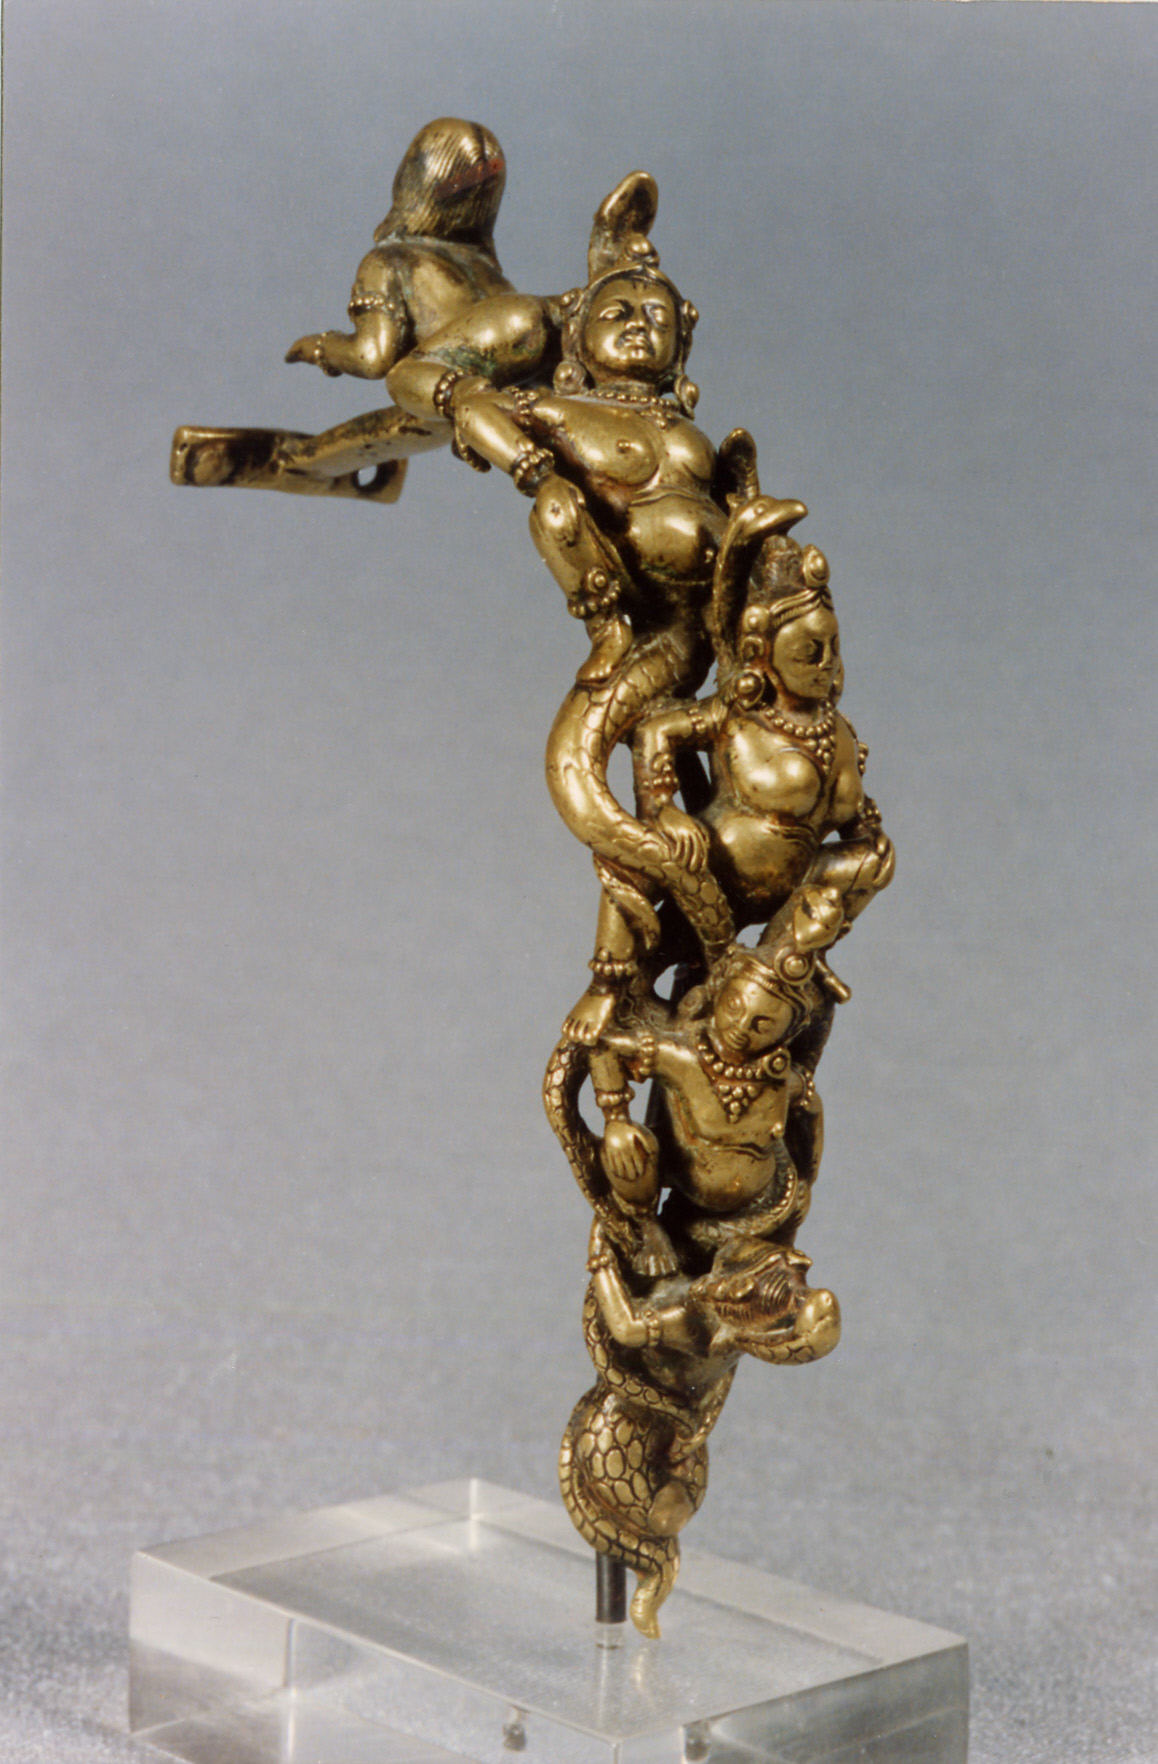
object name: handle for vessel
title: Handle with Intertwined Figures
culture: nepali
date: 1201-1300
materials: copper alloy